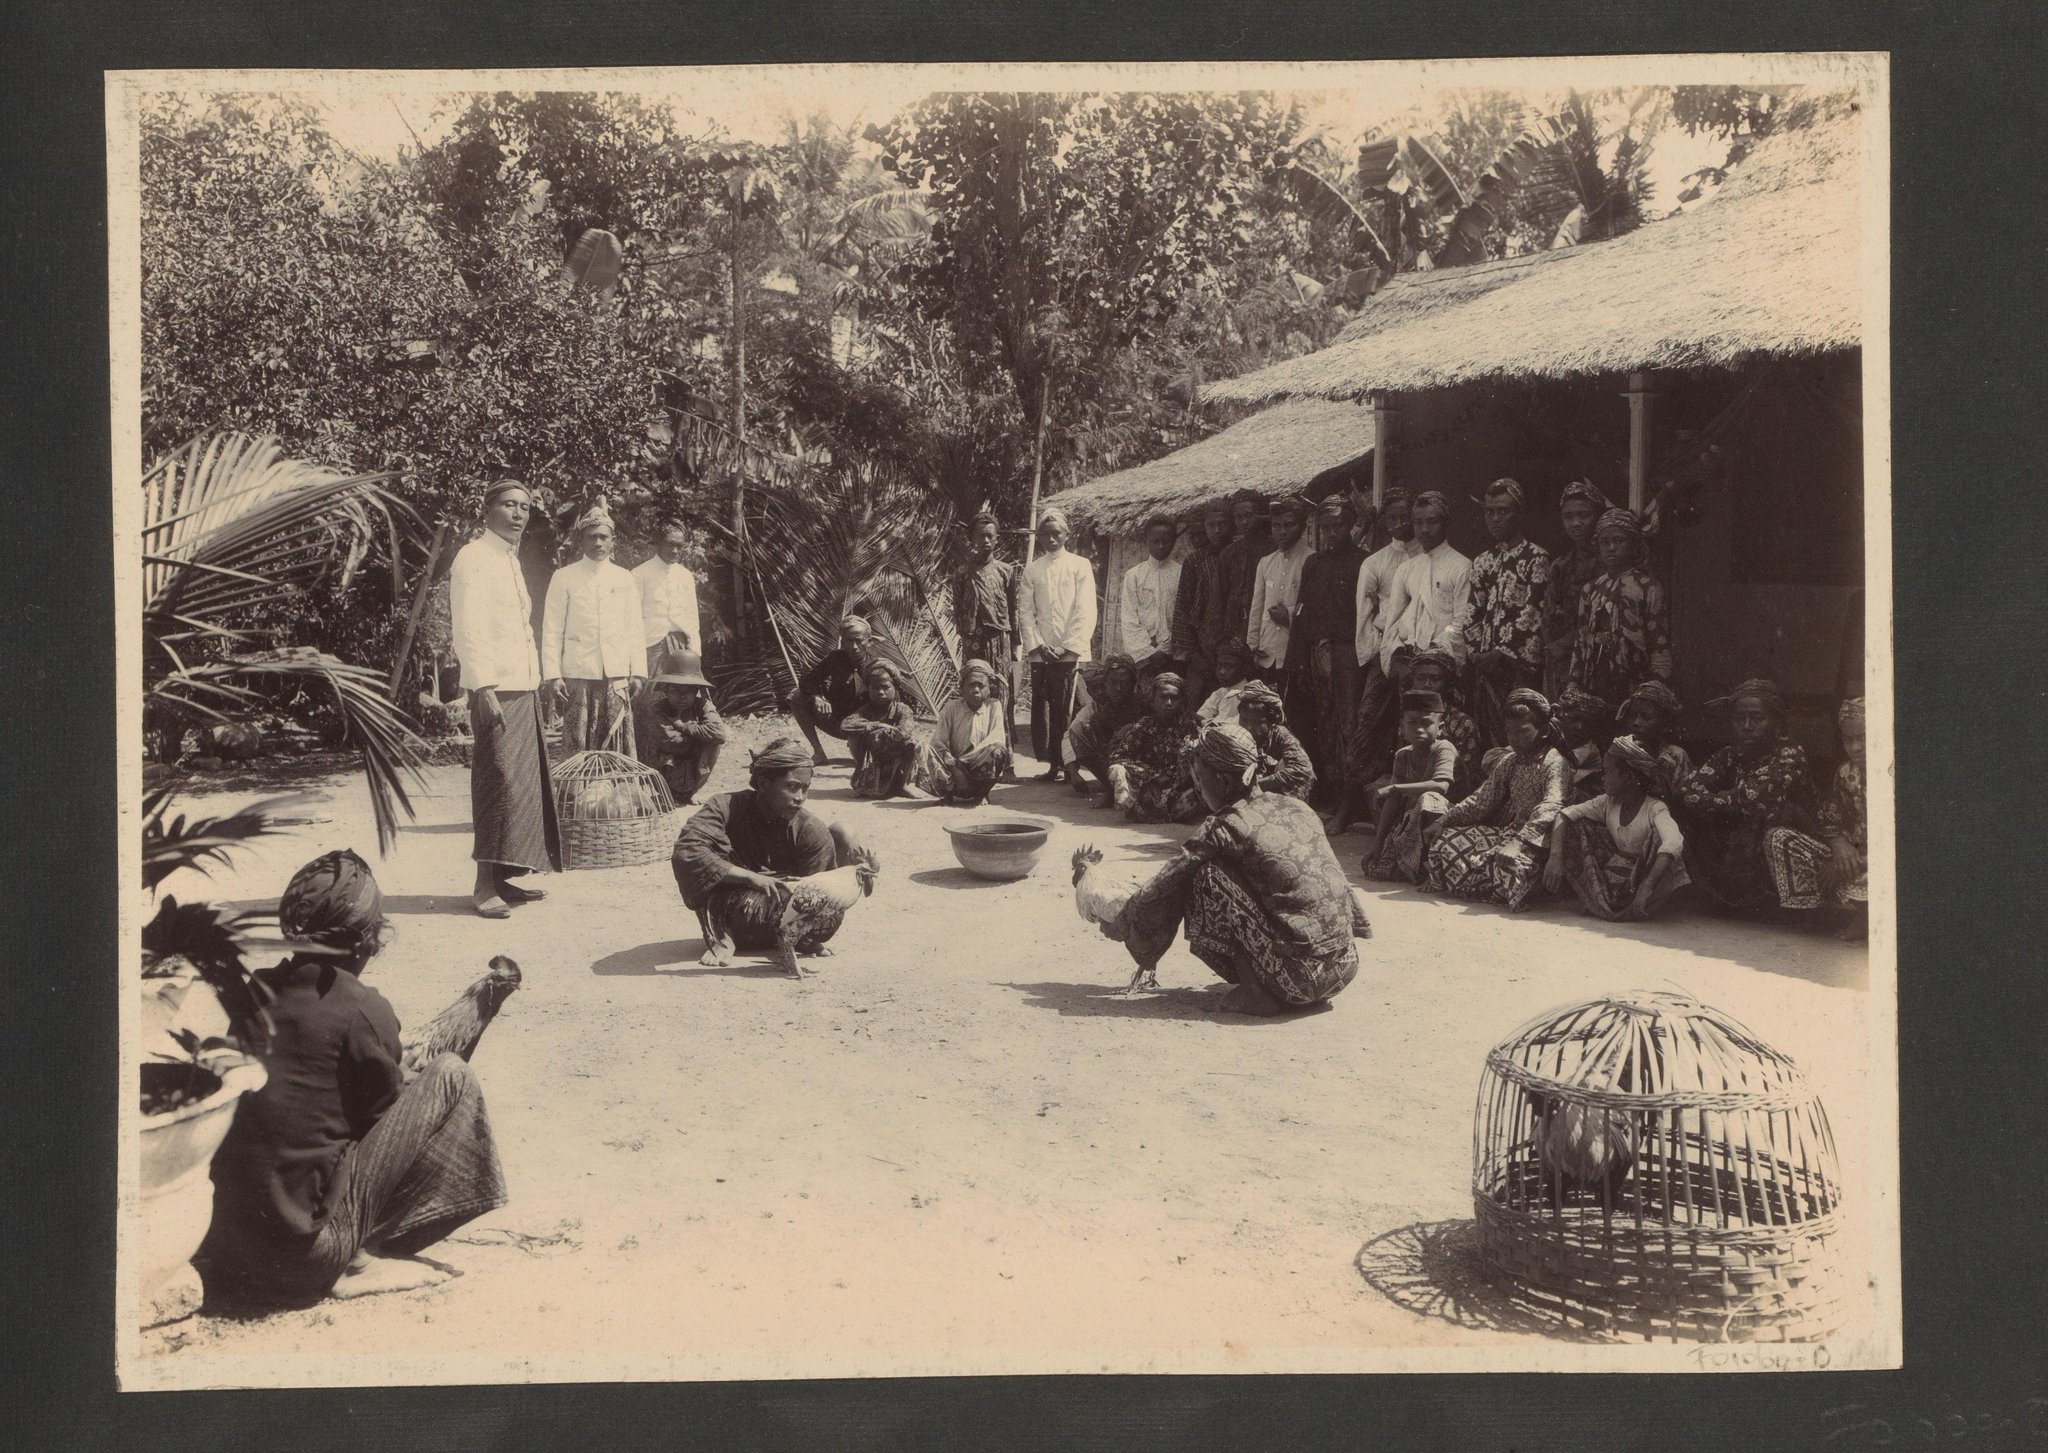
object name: photograph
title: Mannen bij een hanengevecht op een erf in Nederlands-Indië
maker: onnes kurkdjian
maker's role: fotograaf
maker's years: 1851-1903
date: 1912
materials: paper, photographic support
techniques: gelatin silver print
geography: dutch east indies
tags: cock-fighting, dutch east indies, the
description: Onderdeel van Reisalbum met veertig foto's van Nederlands-Indië.